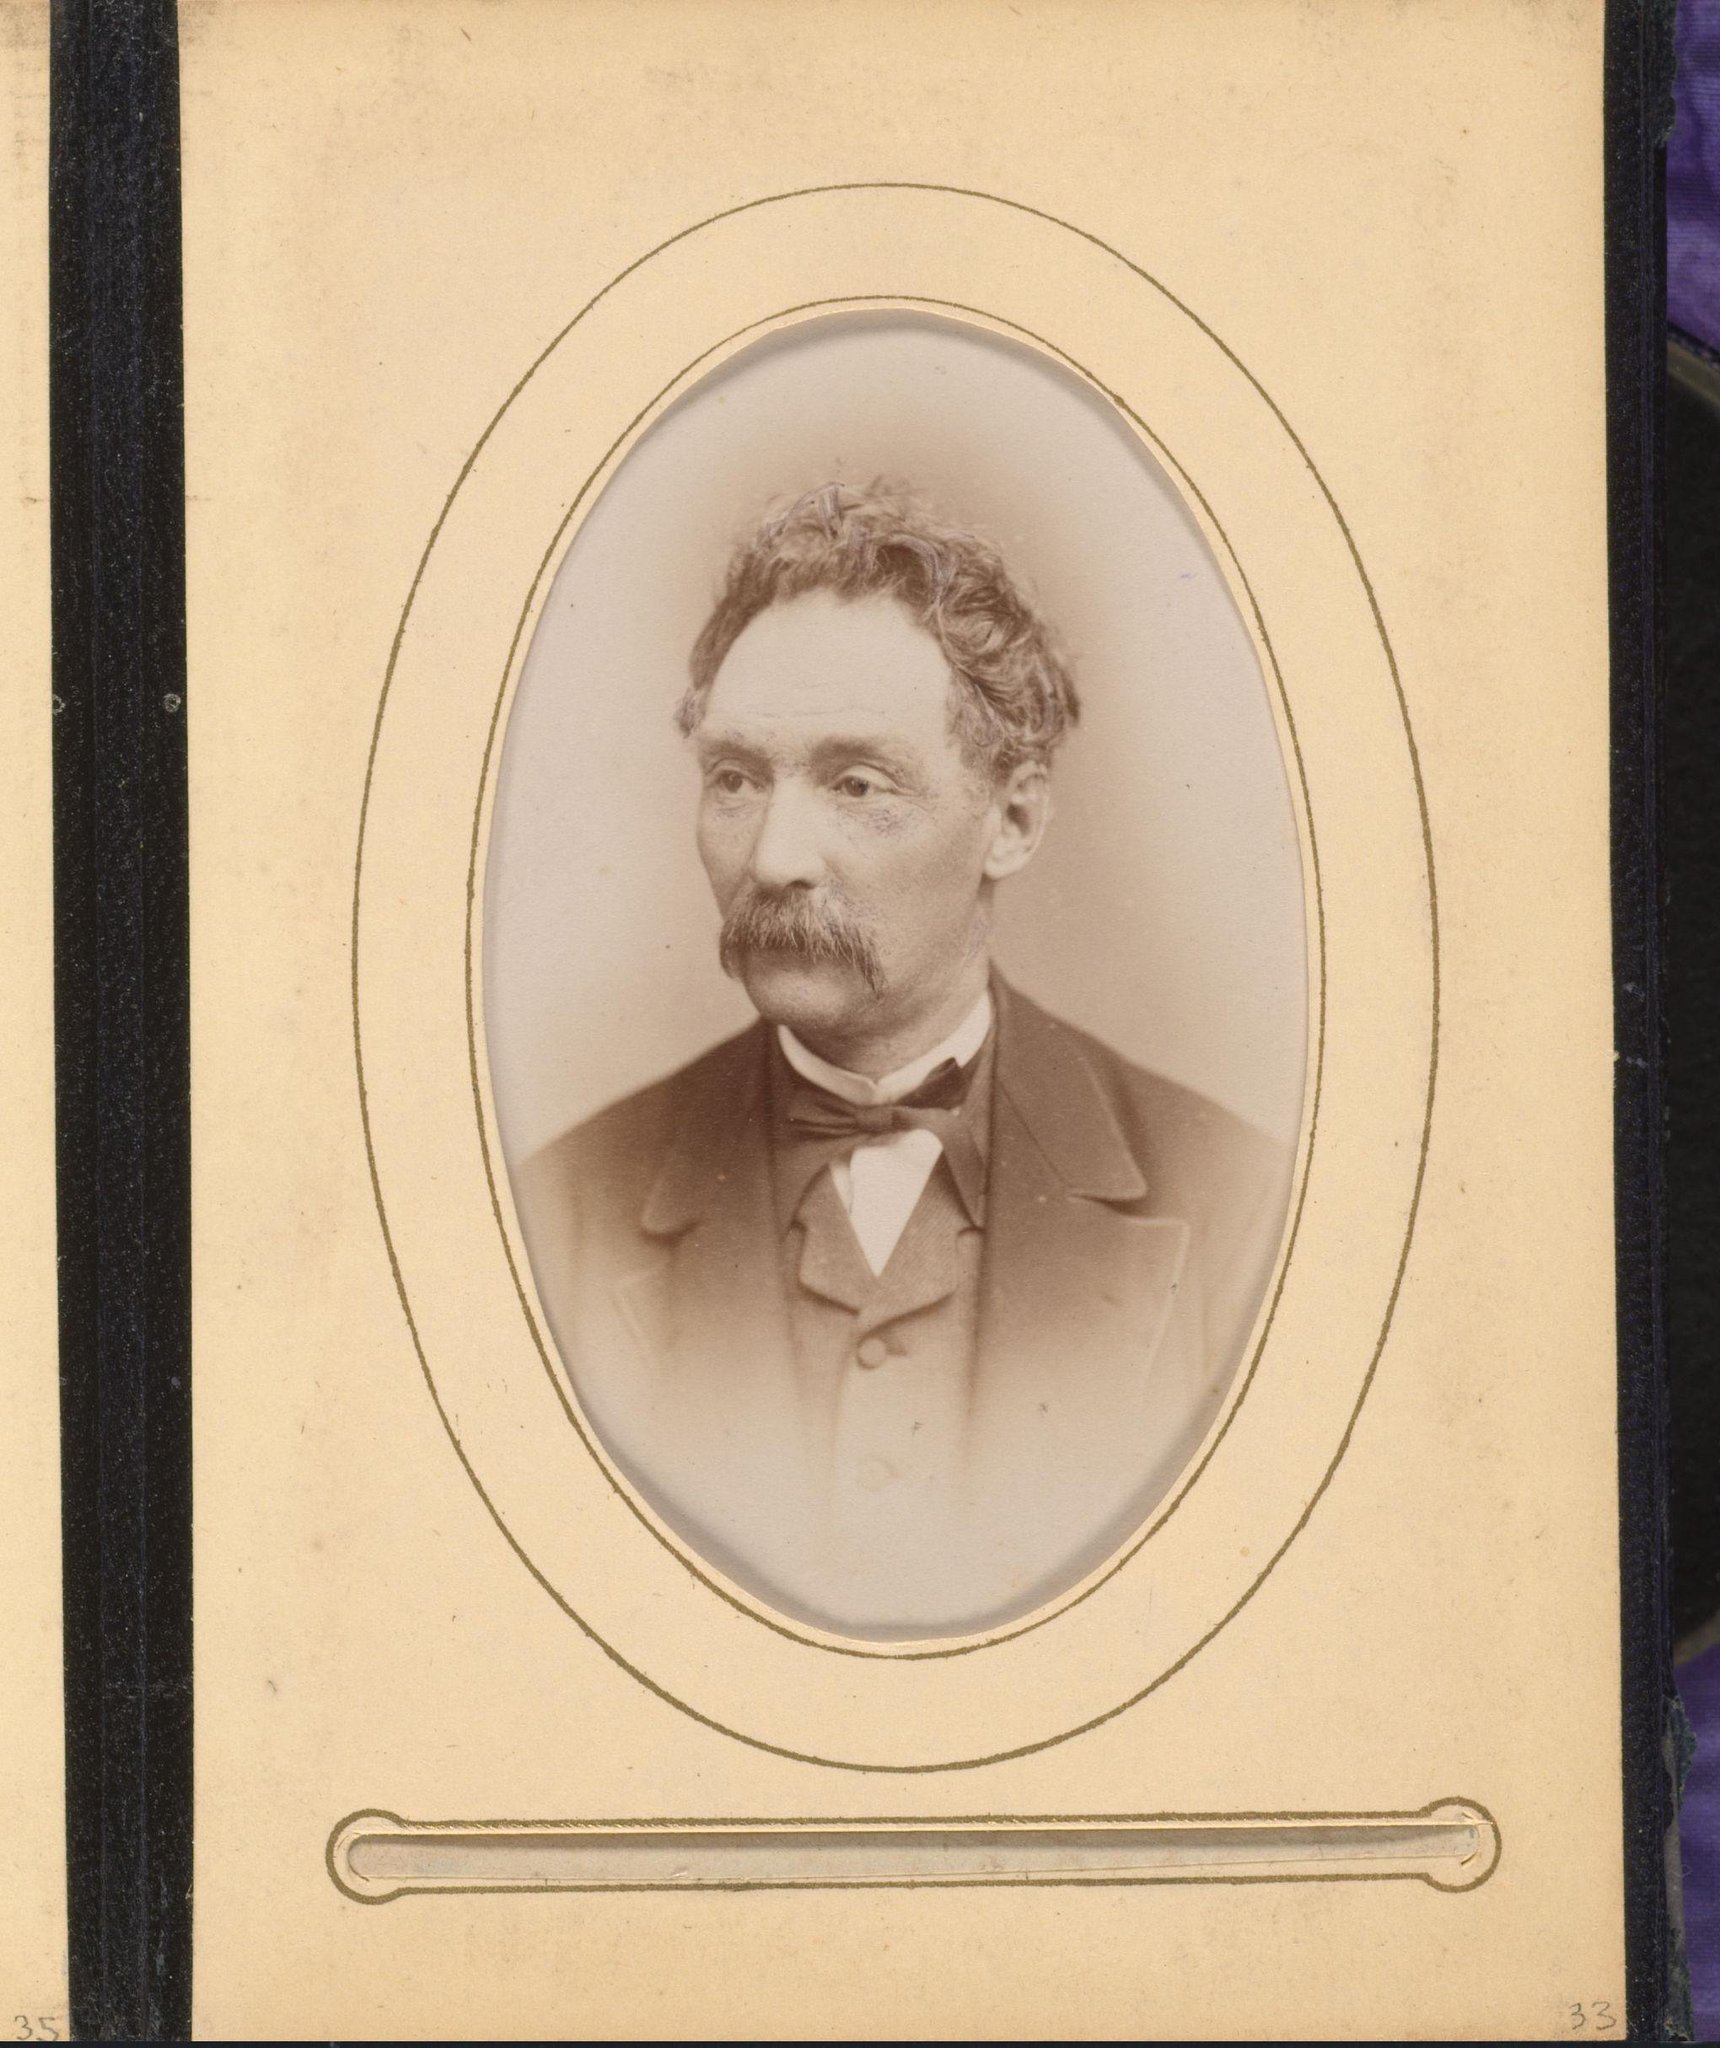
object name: album leaf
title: Portret van een man met snor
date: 1875-1899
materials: cardboard, photographic support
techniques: albumen print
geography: rotterdam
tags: moustache, historical persons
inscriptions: inscription: ‘Atelier/ voor/ Photographie/ HELIOS/ Korte Hoogstraat, 33/ Rotterdam’